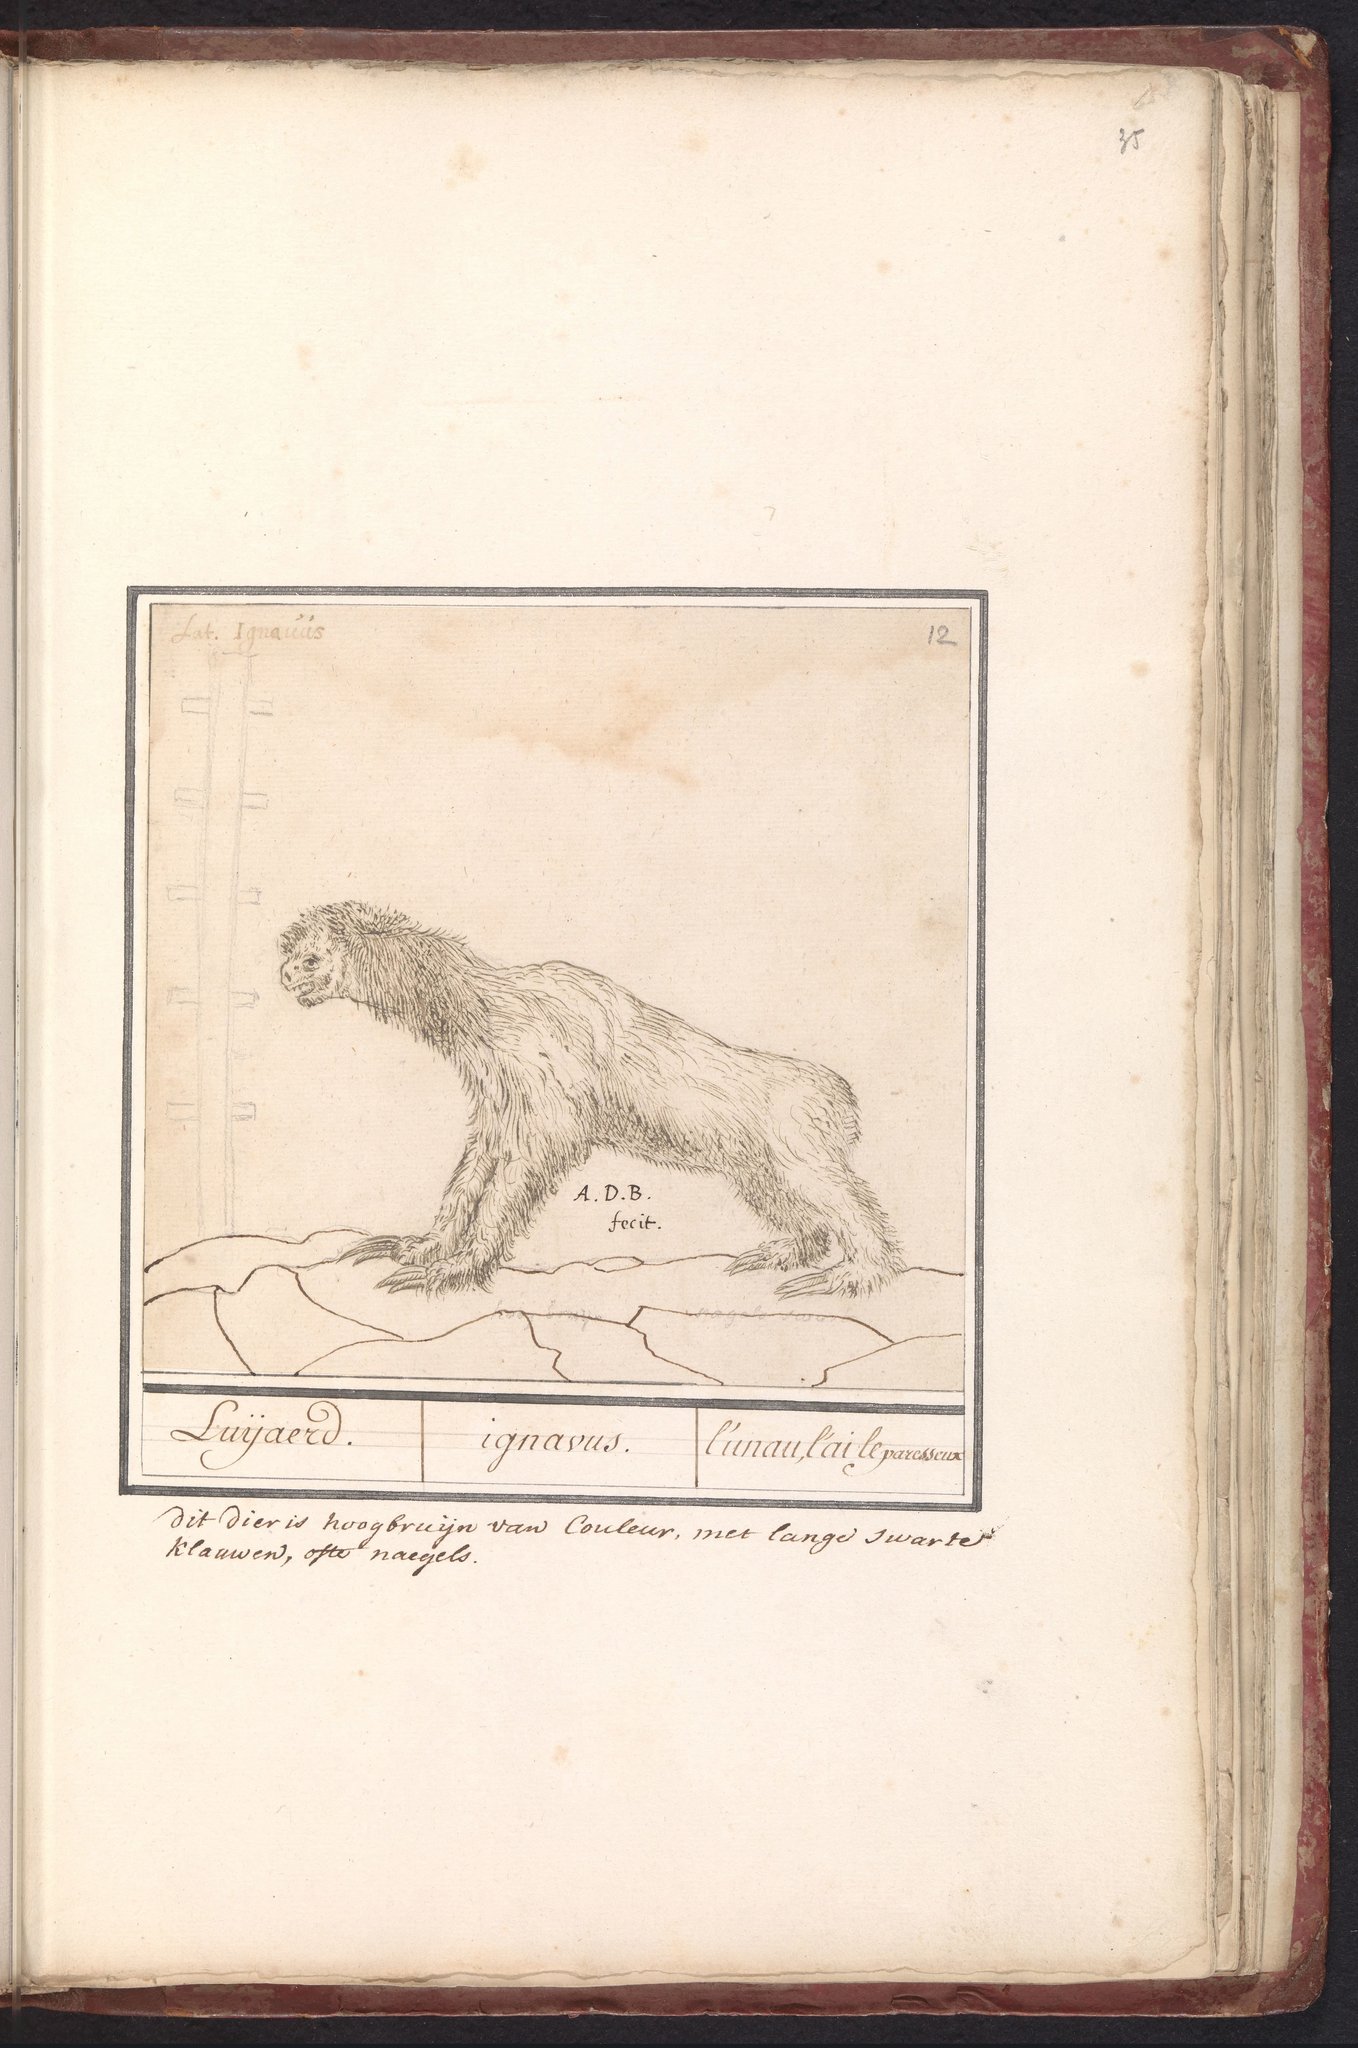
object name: drawing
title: Drievingerige luiaard (Bradypus)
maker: anselmus boëtius de boodt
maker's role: draughtsman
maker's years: 1550-1632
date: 1596-1605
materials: ink, paper, pencil, watercolor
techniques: brush, pen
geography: prague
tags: other mammals (with name)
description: Drievingerige luiaard. Genummerd rechtsboven: 12. Met de naam in het Latijn. Tweeregelig annotatie in het Nederlands toegevoegd op het blad. Onderdeel van het tweede album met tekeningen van viervoeters. Tweede van twaalf albums met tekeningen van dieren, vogels en planten bekend rond 1600, gemaakt in opdracht van keizer Rudolf II. Met toelichting in Nederlands, Latijn en Frans.